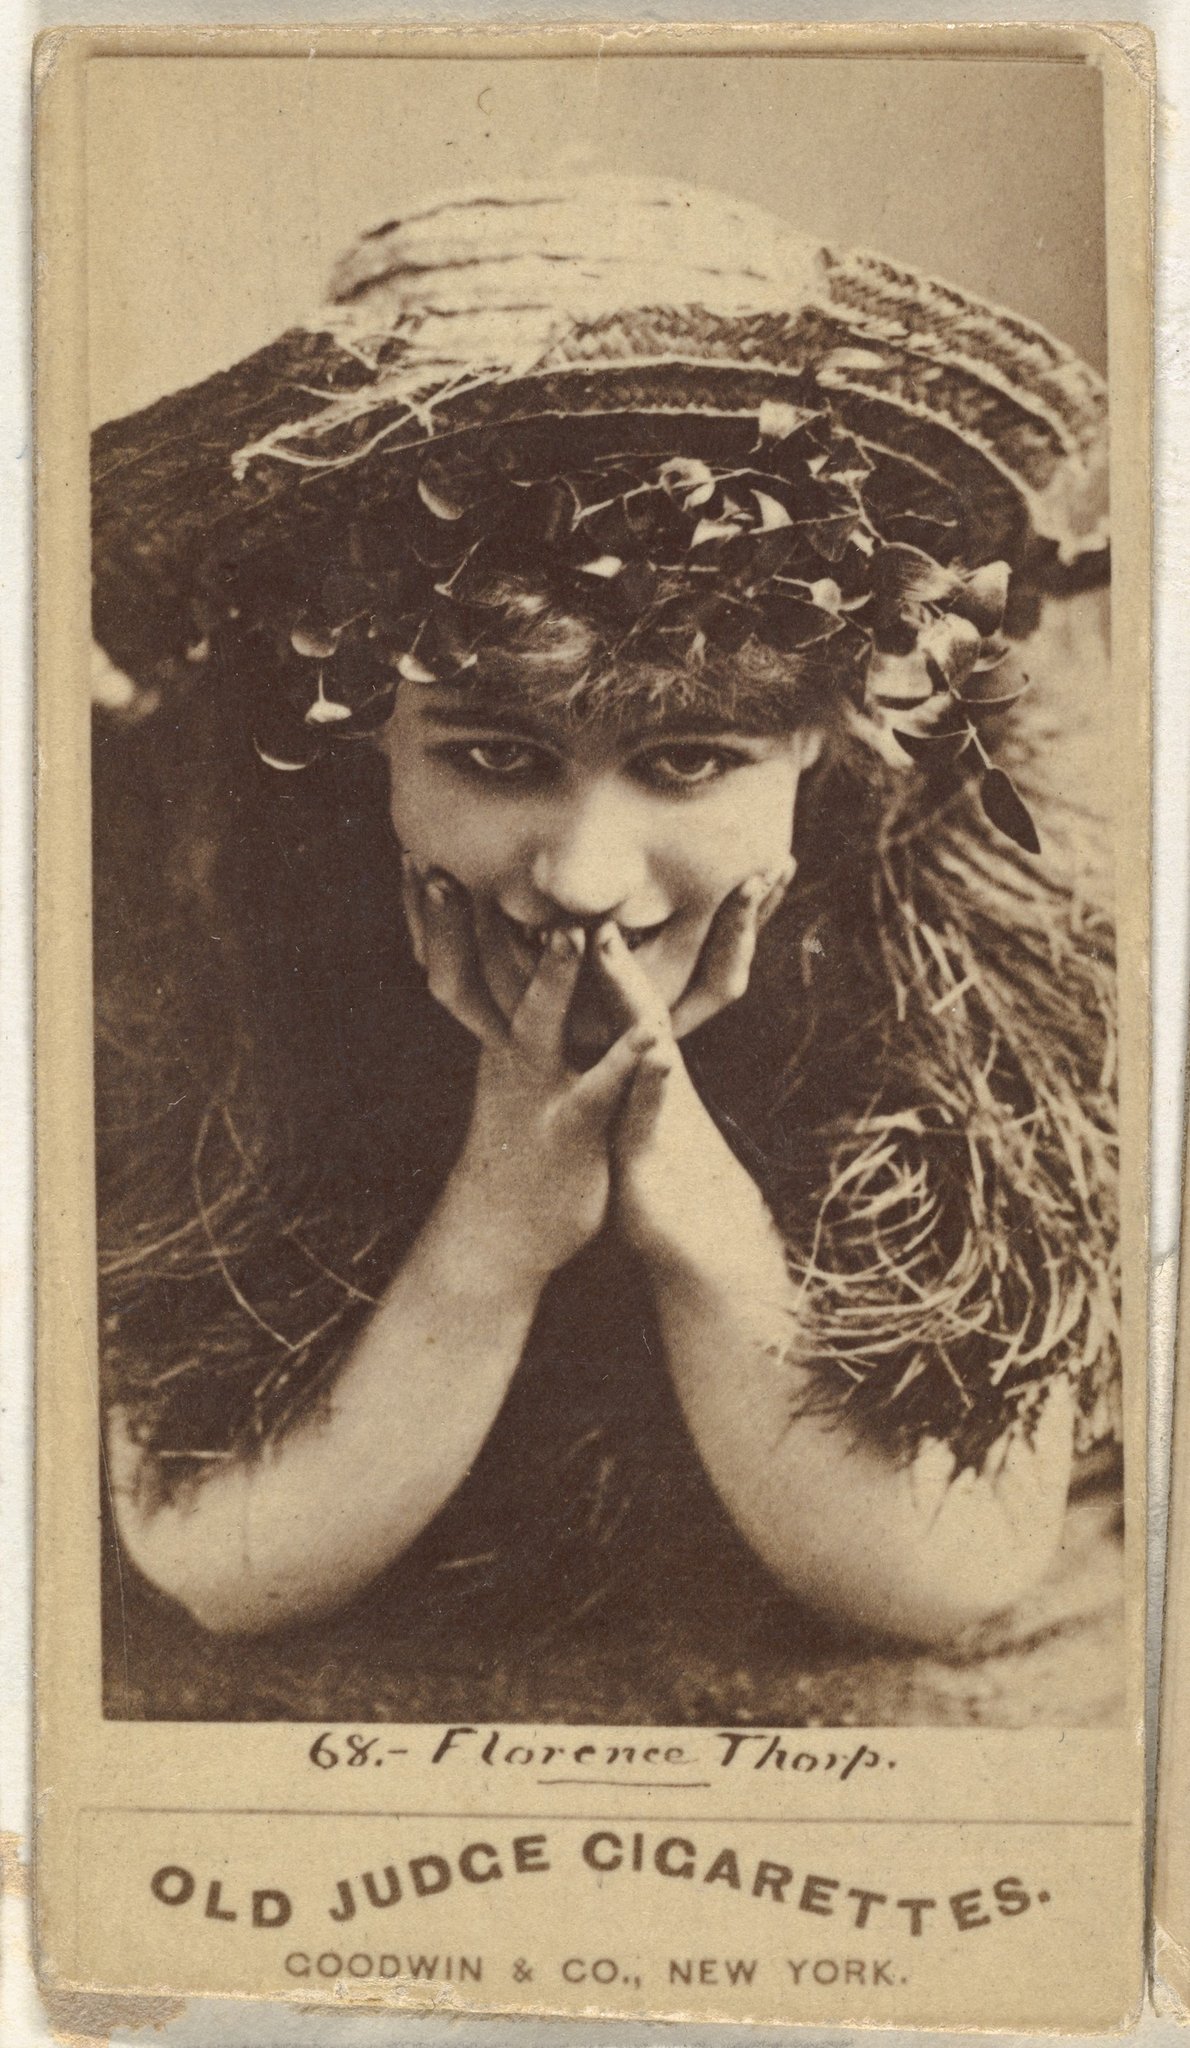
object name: photograph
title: Florence Thorp, from the Actors and Actresses series (N171) for Old Judge Cigarettes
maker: goodwin & company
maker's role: publisher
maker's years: 1850-1950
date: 1886-1890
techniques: albumen silver print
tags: portraits,women,actresses